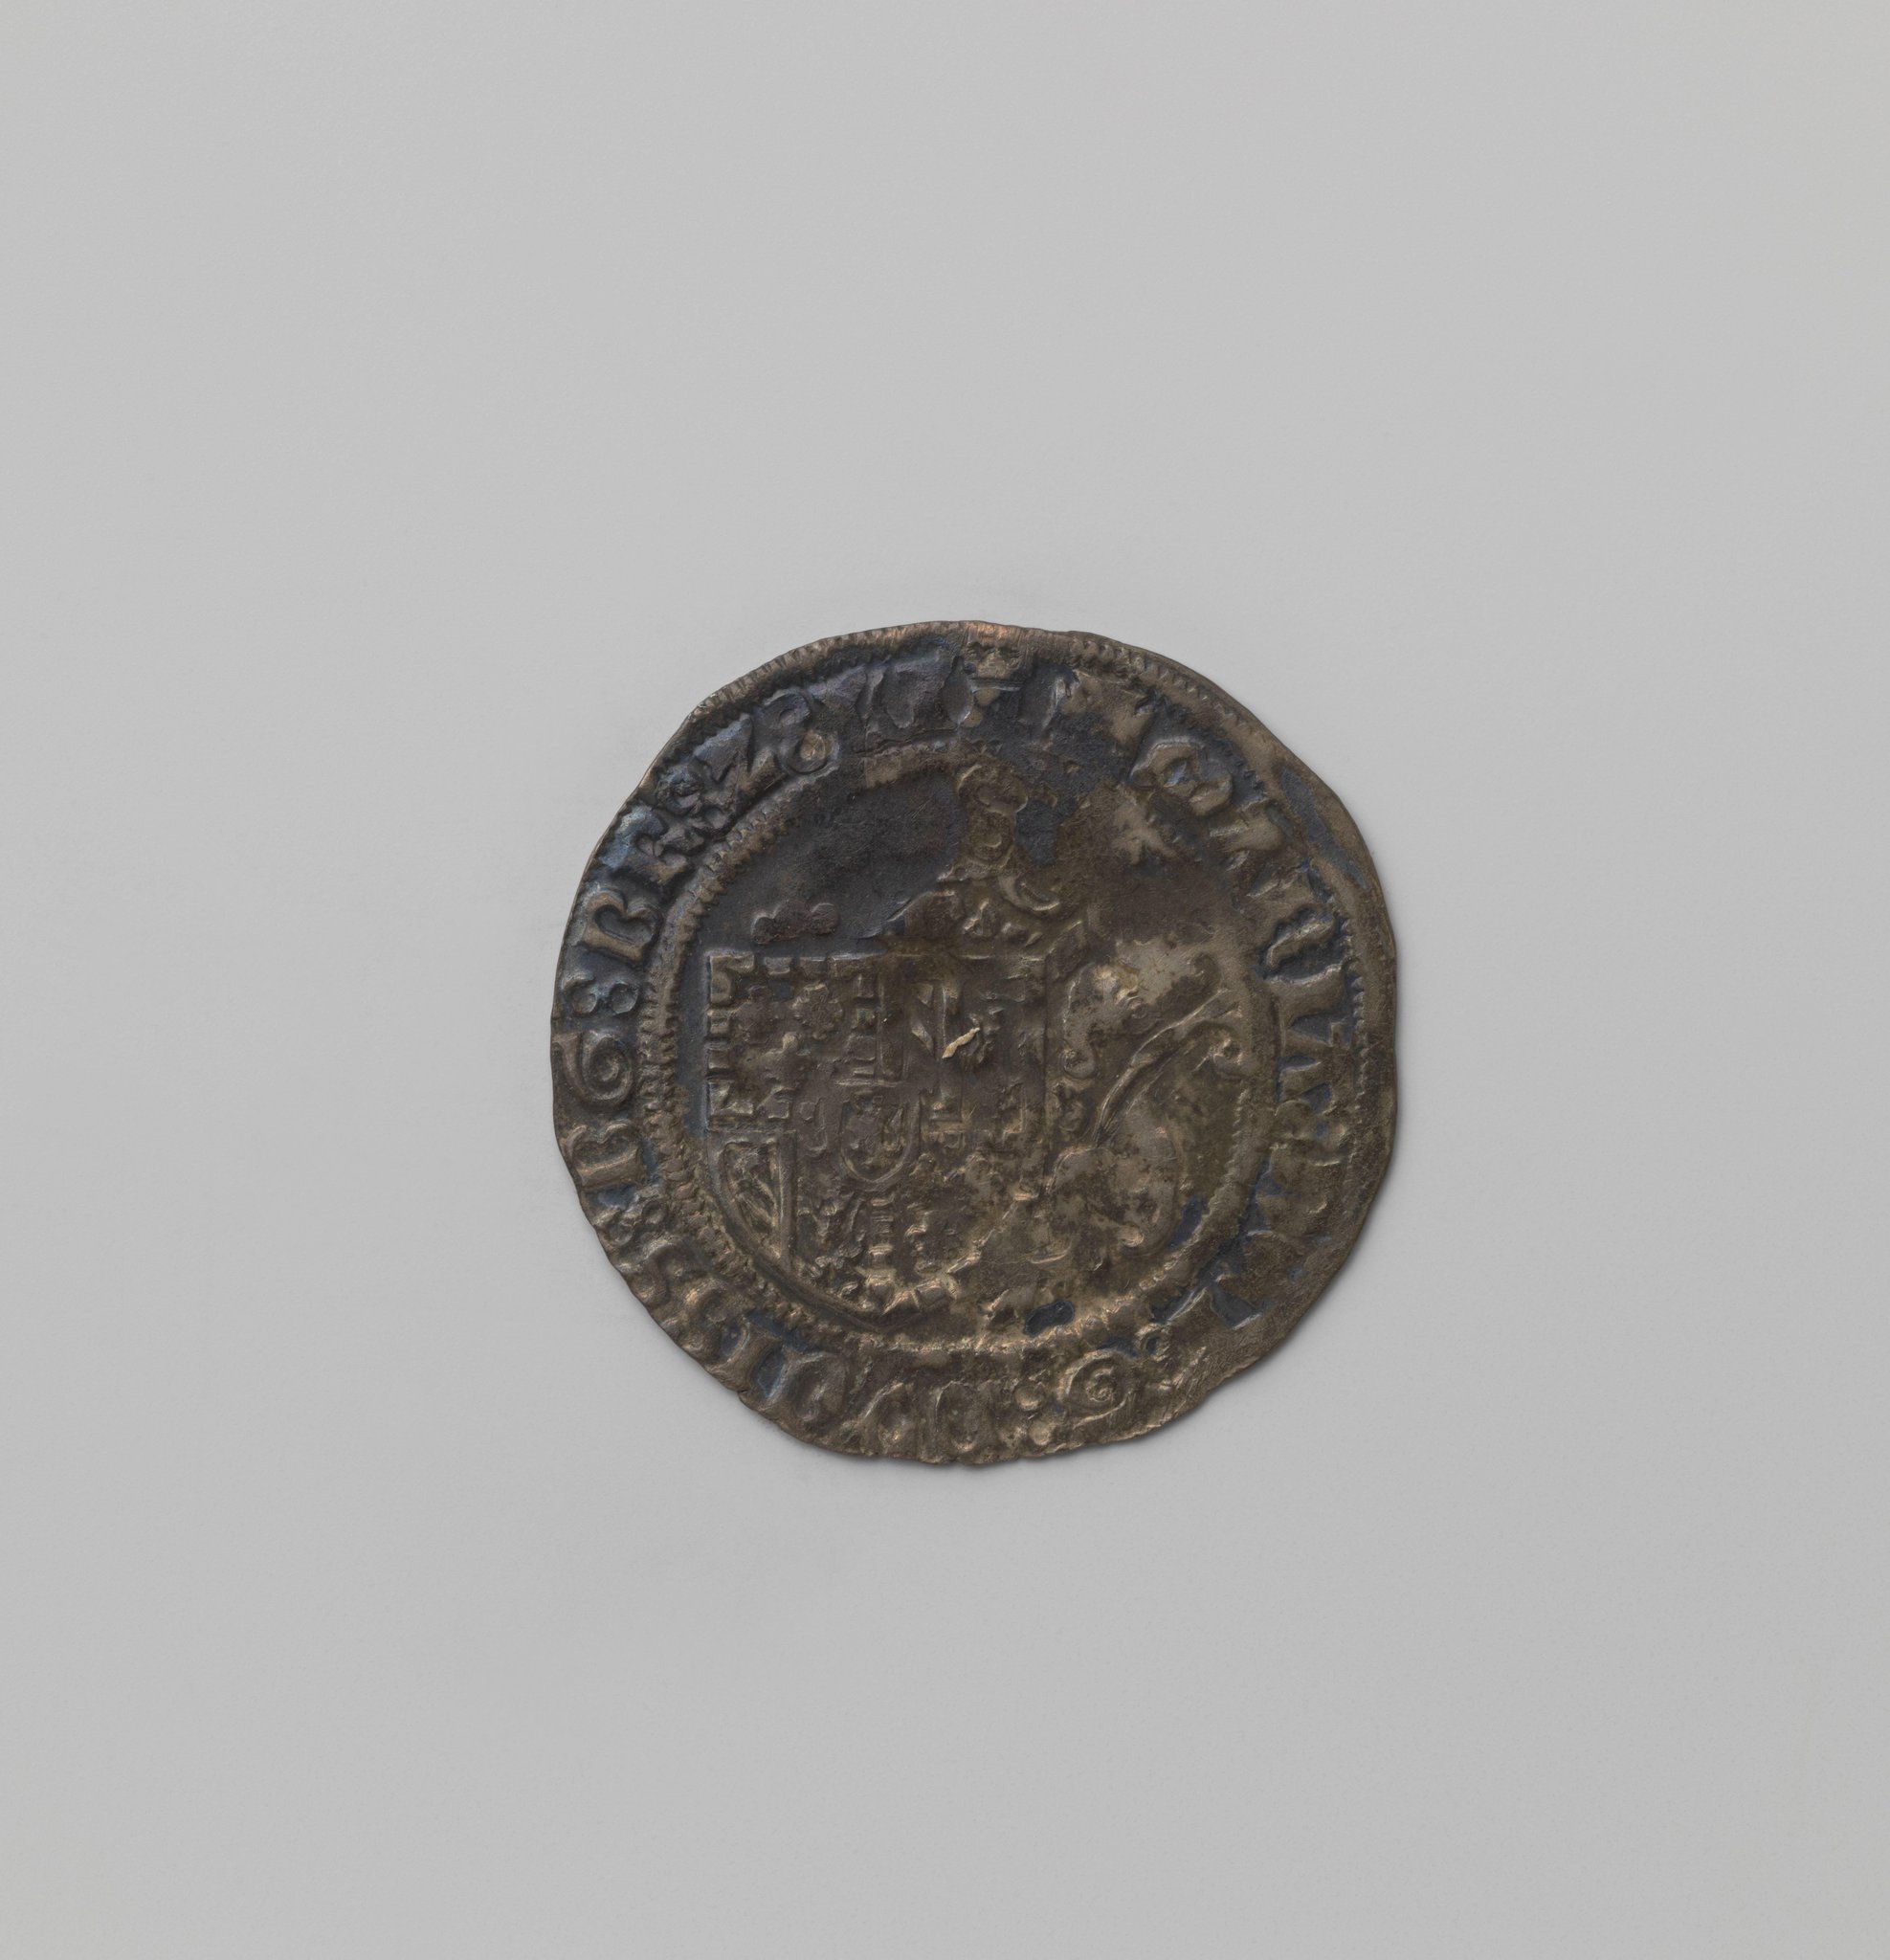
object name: vuurijzer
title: Brabant, Maria van Bourgondië, vuurijzer, 1479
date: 1479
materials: silver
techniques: striking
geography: antwerp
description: Zilveren munt. Voorzijde: zittende leeuw naar links met voor zich wapenschild. Daarboven vuurijzer. Toren aan het eind van het omschrift. Keerzijde: kort gebloemd kruis. Jaartal in omschrift.